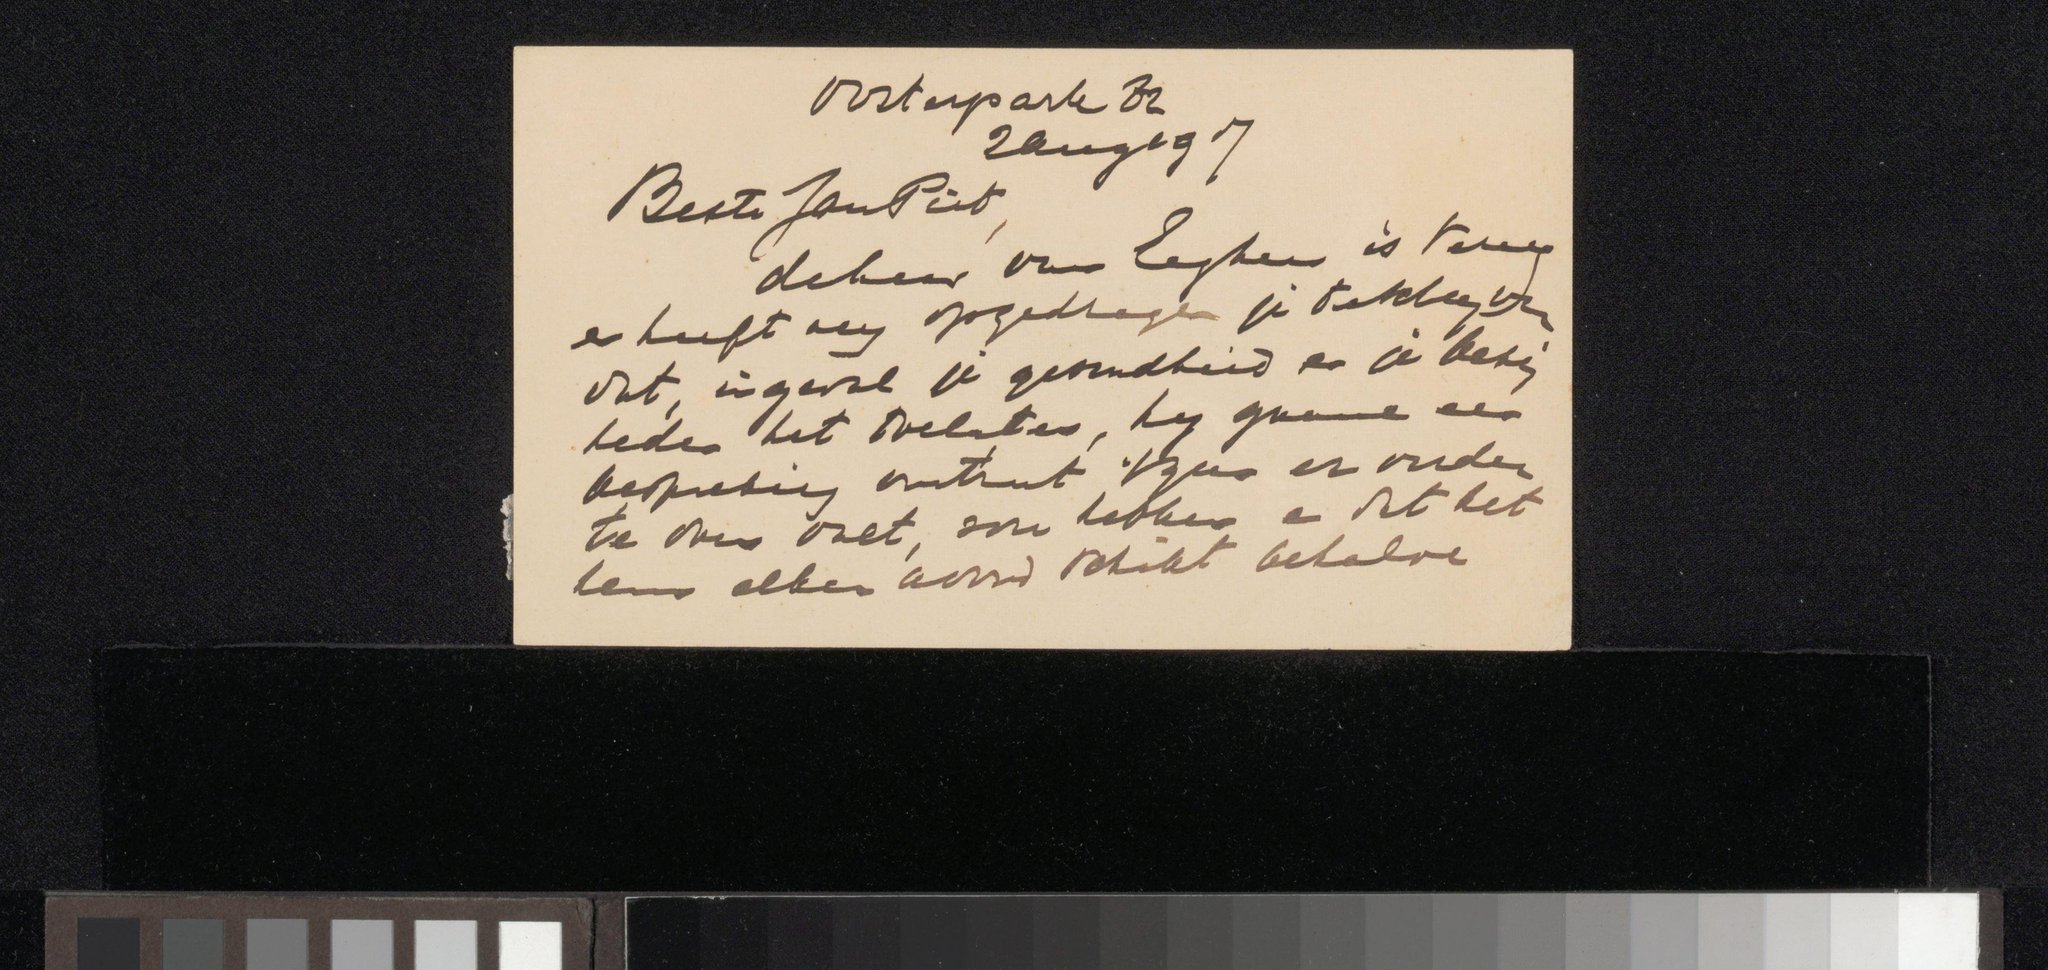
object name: letter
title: Brief aan Jan Veth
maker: willem witsen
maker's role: draughtsman, painter, print maker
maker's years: 1860-1923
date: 1917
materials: cardboard, ink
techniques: pen, writing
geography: amsterdam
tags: dordrecht, designer, jan veth, the hague, ed gerdes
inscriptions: collector's mark: ‘RPK’